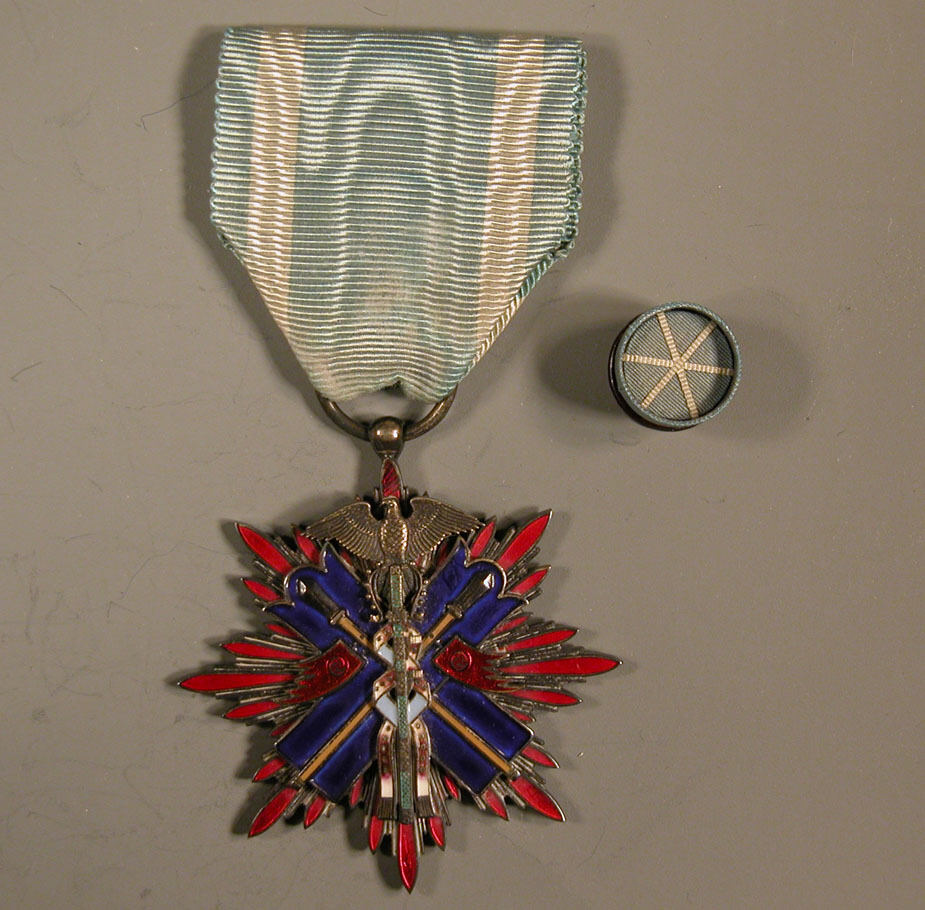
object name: medal and button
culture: japanese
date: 1867-1900